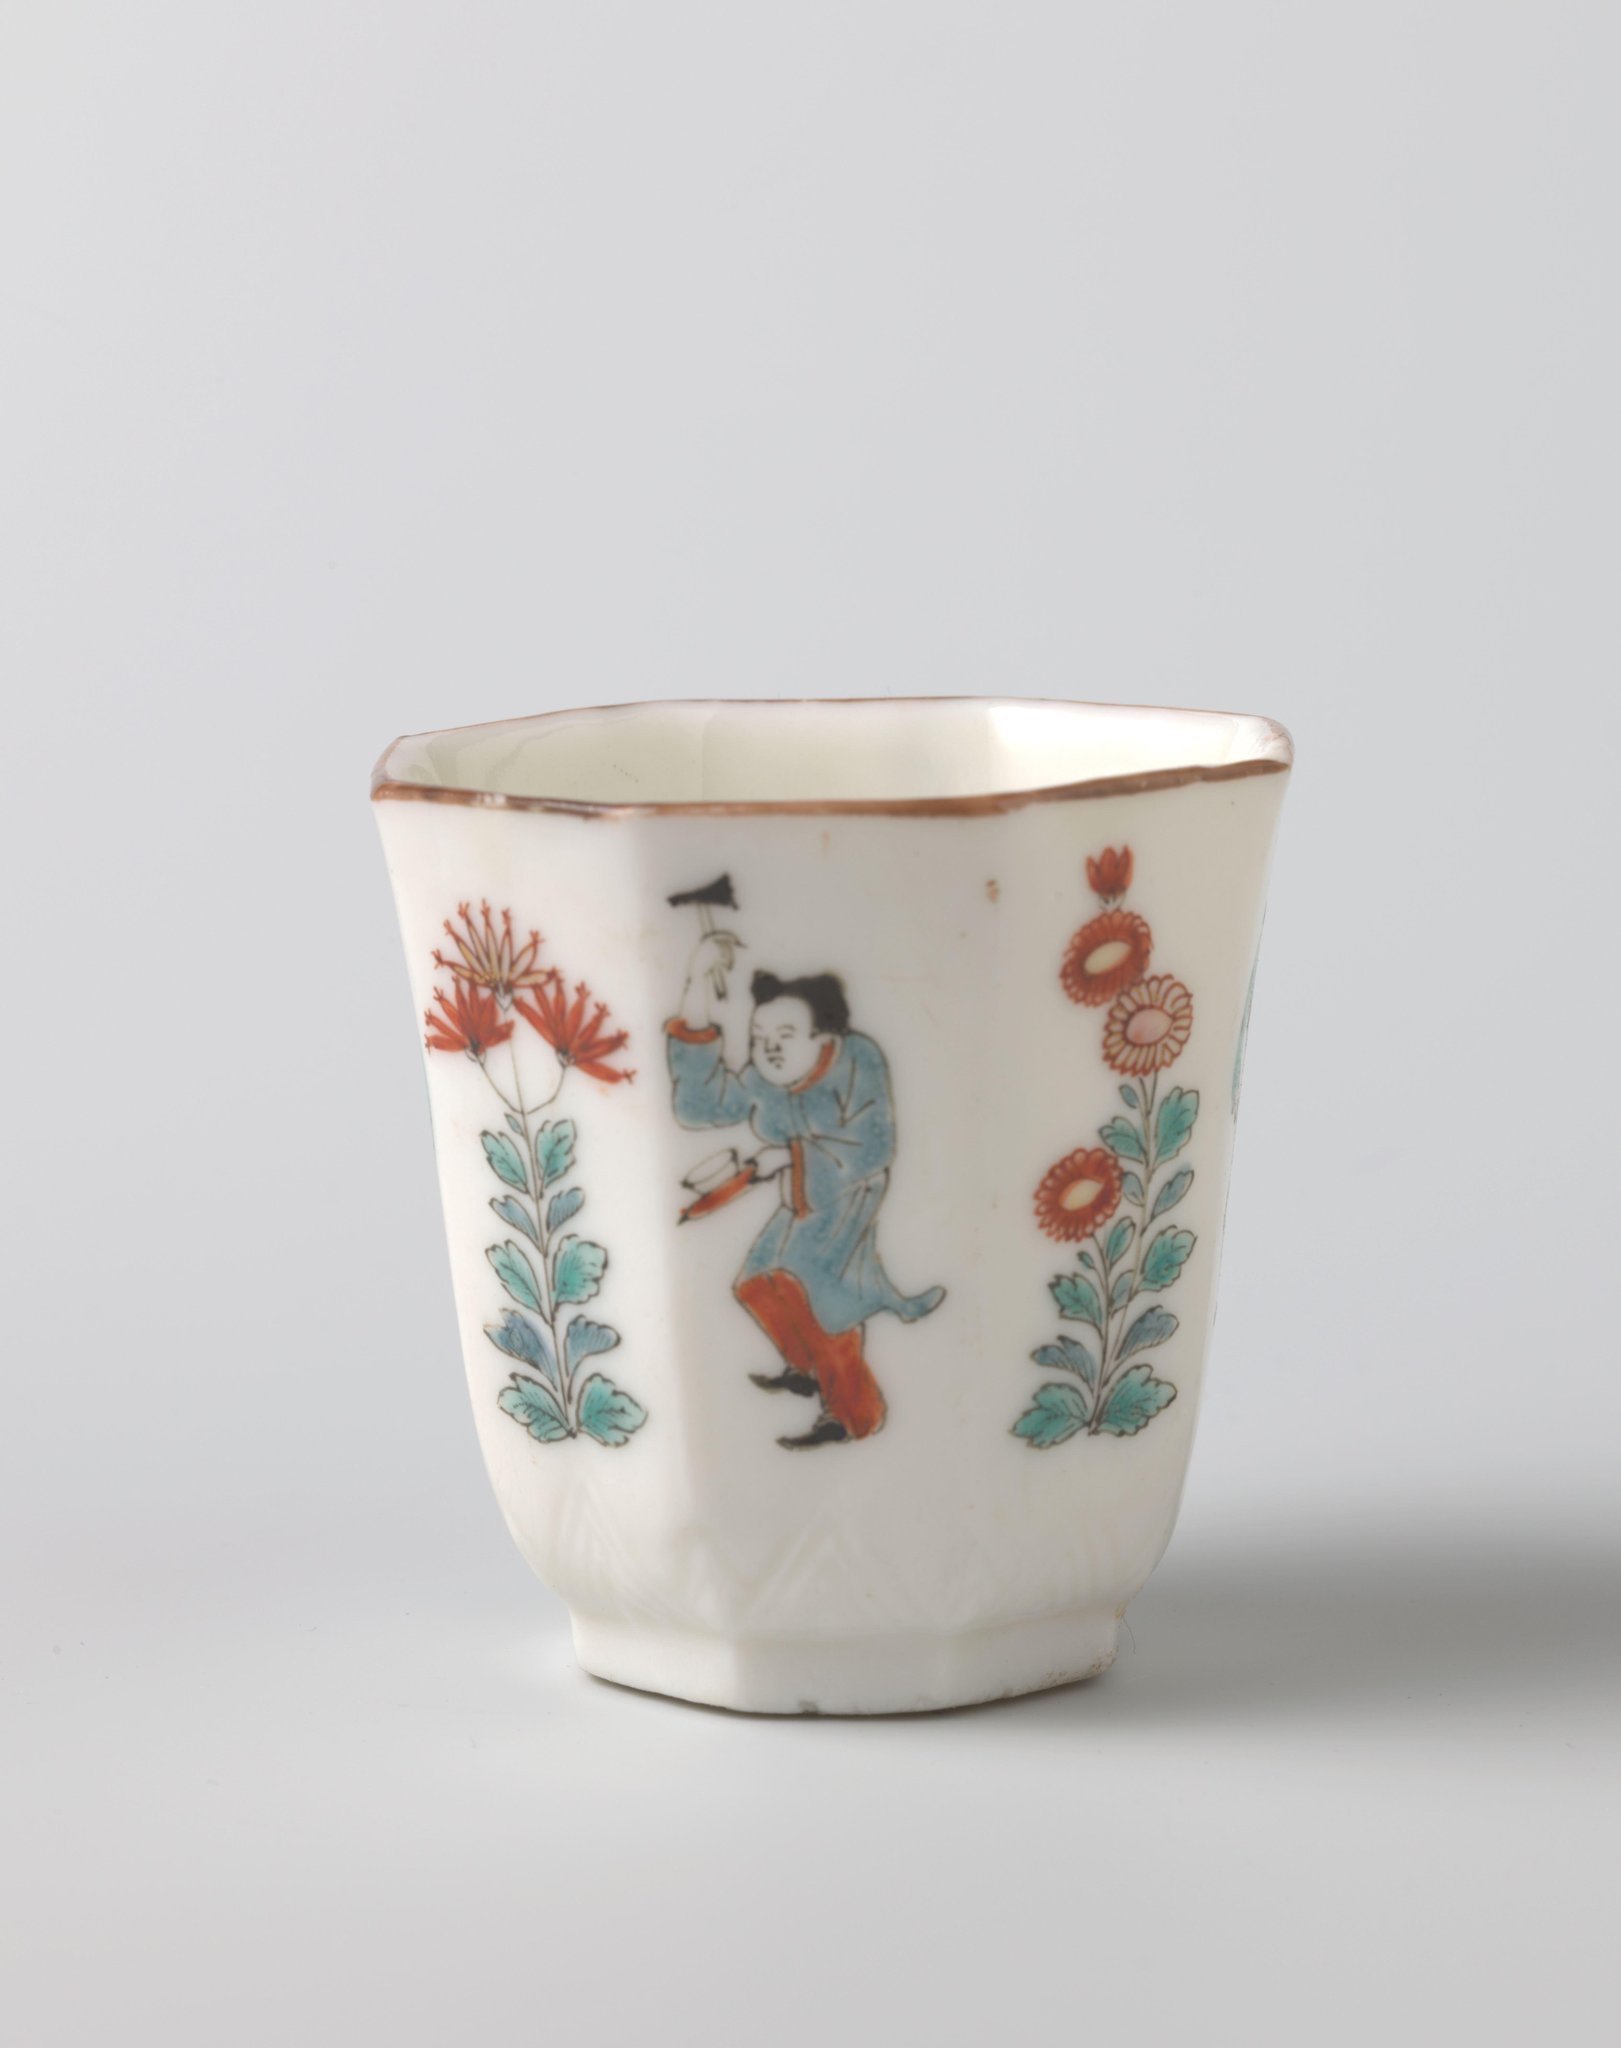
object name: bowl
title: Octagonal cup with dancing boys and flowering plants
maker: Anonymous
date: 1700-1720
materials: glaze, gold, paint, porcelain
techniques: firing, forming, gilding, turning, vitrification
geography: dehua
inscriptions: mark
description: AK-NM-6402 Zes koppen • Gekleurd porselein – gedecoreerd in Nederland • Onderdeel van Royers porseleincollectie Dit zijn blanc de Chine kopjes die in Nederland zijn beschilderd. Zie hiervoor ook de toelichting bij de flessen AK-NM-6464. Waarschijnlijk zijn afkomstig uit de collectie van Royers oudtante Susanna Louise Huygens (1714-1785). Royer kocht voor een groot bedrag uit haar nalatenschap, en omdat nergens gespecificeerd is welke stukken dat waren, is een vergelijking van de beschrijvingen in Susanna Louises boedel en Royers voorwerpen, de beste manier om de Huygens-herkomst aannemelijk te maken. In de boedel vinden we bij het gekleurde porselein: ‘Ses achtkantige kandeelkoppen, met Chineesche figuuren, bloemwerk, bruine rand.’ Ik vind dit een vrij overtuigende match. Tot mijn spijt is het niet gelukt een voorbeeld te vinden dat de Nederlandse porseleinschilder gebruikte voor de musicerende mannetjes. Het is niet te vinden bij Pieter Schenks Chinese en Vremden Nasie of Nieuw Geinventeerde Sineesen en niet in de Schulz codex uit Meissen [Rudi 2010]. Blanc de Chine werd met enige regelmaat in Nederland en elders beschilderd. Er zijn dan ook vrij veel voorbeelden te vinden van vergelijkbare (hoewel niet identieke) kopjes [Ayers 1990, nr. 270; Krahl & Harrison-Hall 1994, nr. 149, Espir 2005, p. 212, afb. 10]. Bronnen: John Ayers, Porcelain for palaces: the fashion for Japan in Europe 1650-1750 (tent.cat. British Museum), Z.pl., 1990. Regina Krahl and Jessica Harrison-Hall, Ancient Chinese trade ceramics from the British Museum, London, Taipei, 1994. Helen Espir, European decoration on oriental porcelain 1700-1830, Londen, 2005. Thomas Rudi (red.), Exotische Welten: der Schulz-Codex und das frühe Meissener Porzellan, Leipzig, 2010.